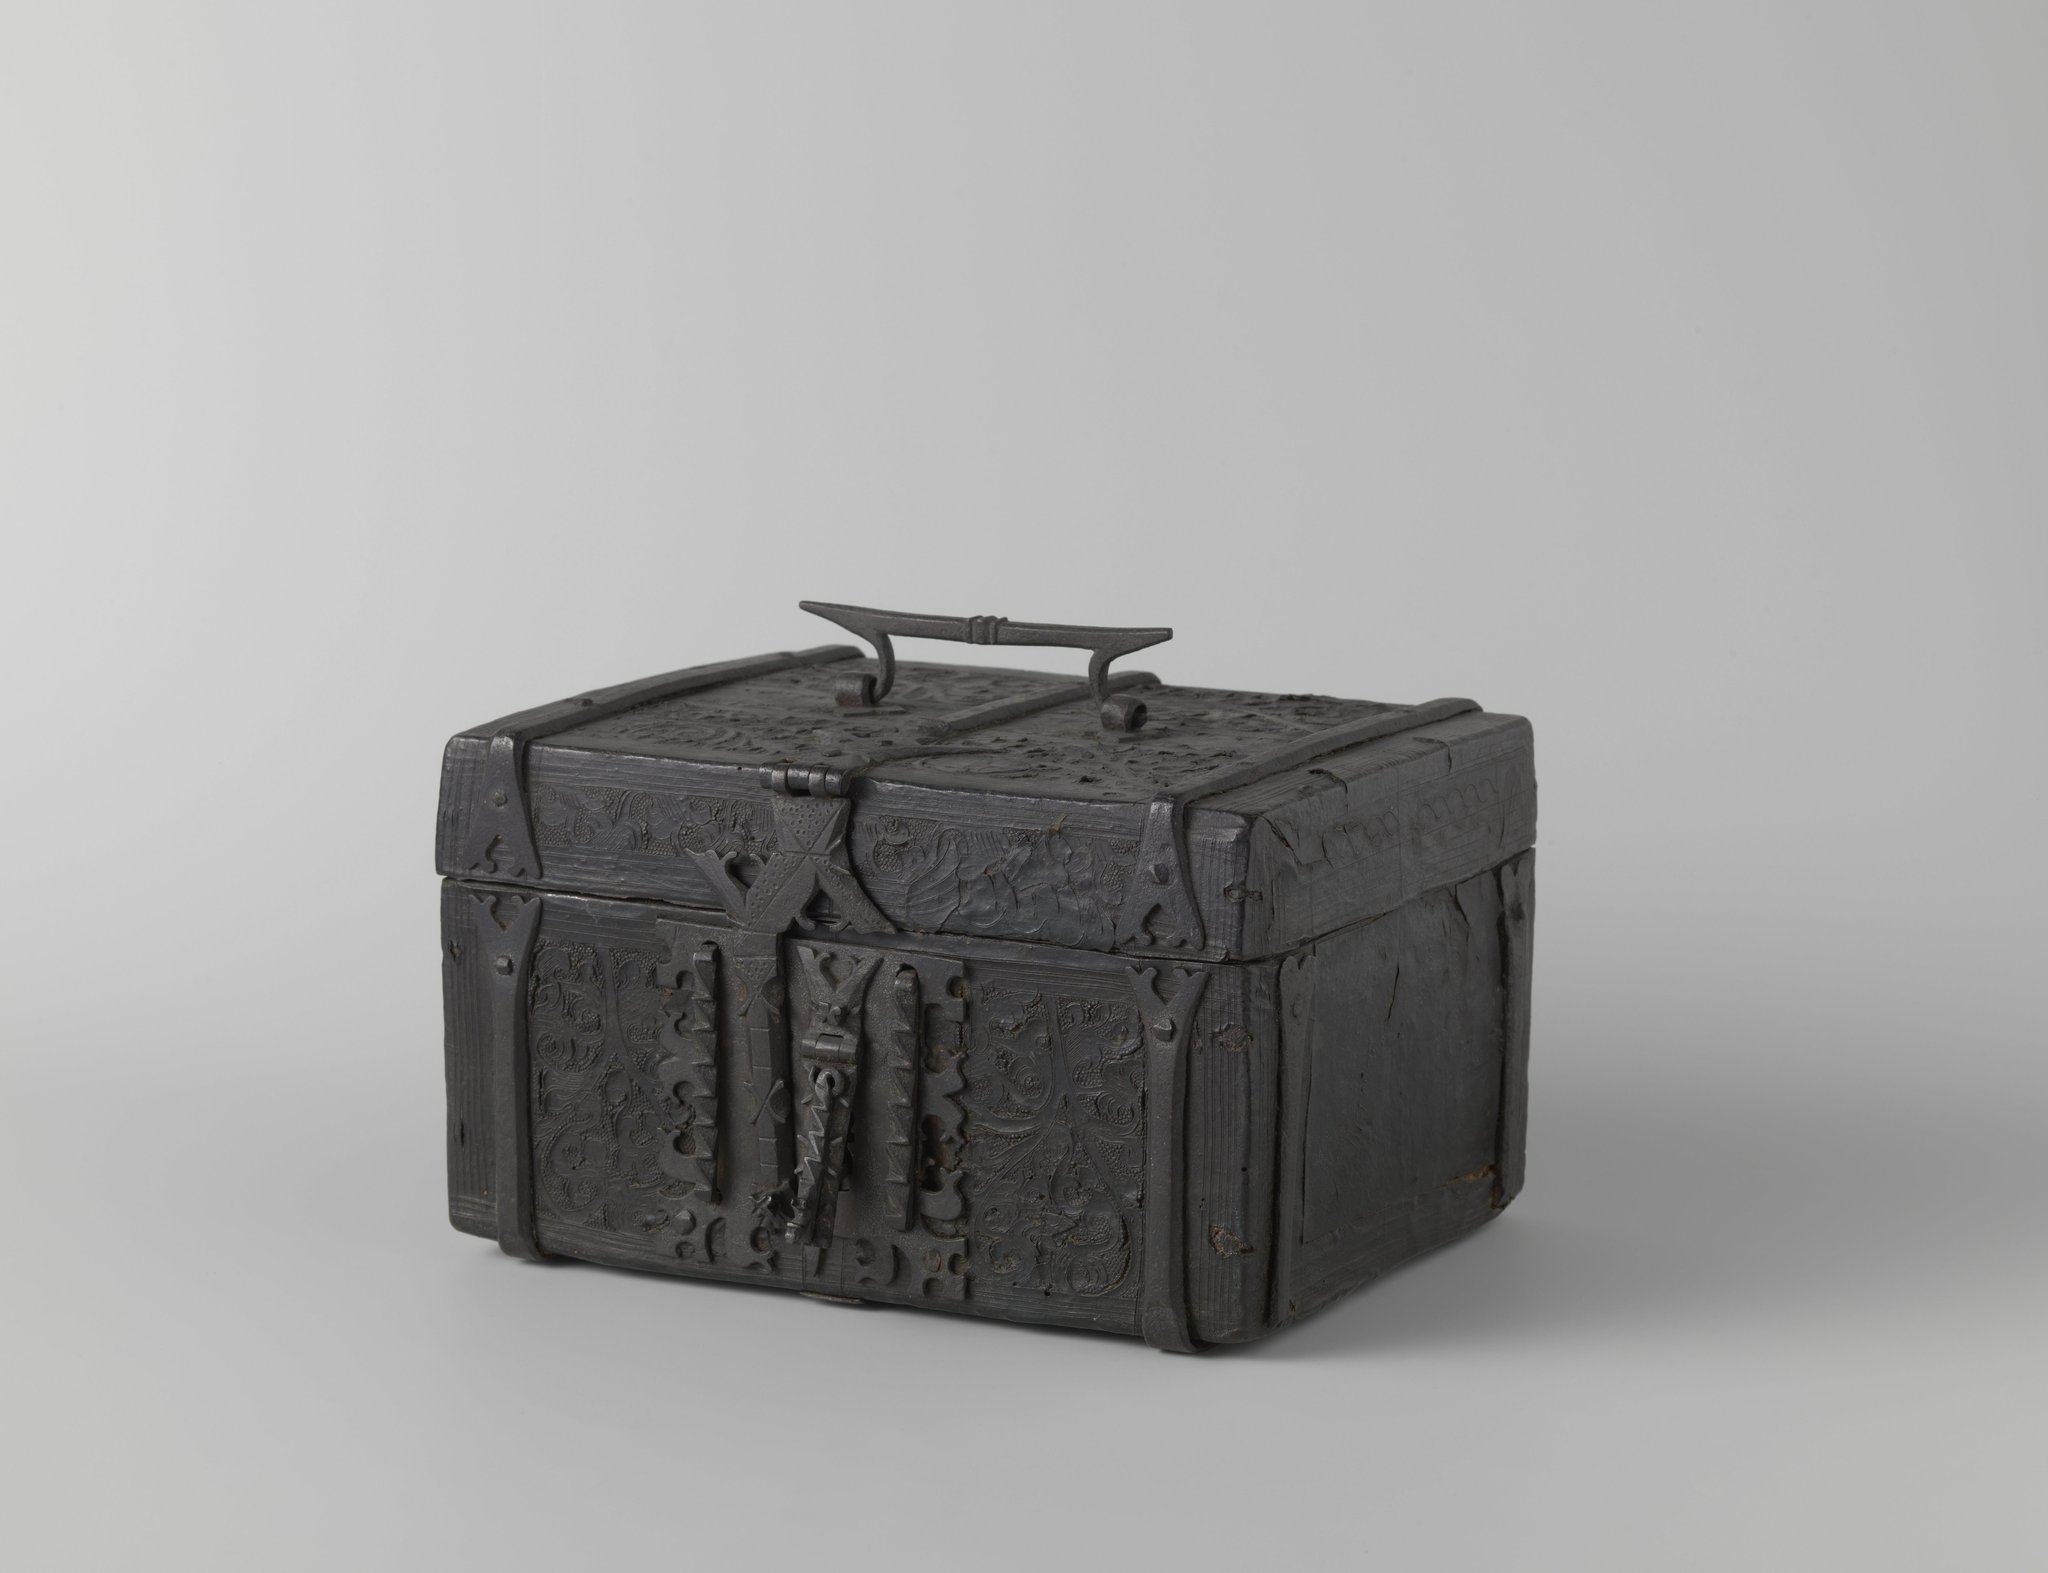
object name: chest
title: Kist van hout, overtrokken met zwart leer en voorzien van versierd ijzeren beslag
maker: Anonymous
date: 1500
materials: iron, leather, wood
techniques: cutting, forging, striking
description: Kist van hout, overtrokken met zwart leer en voorzien van versierd ijzeren beslag. De ornamenten in het leer zijin gesneden en geslagen. Banden, slot en hengsel zijn van gesmeed ijzer en rijk versierd. De binnenkant is met rood leer bekleed.